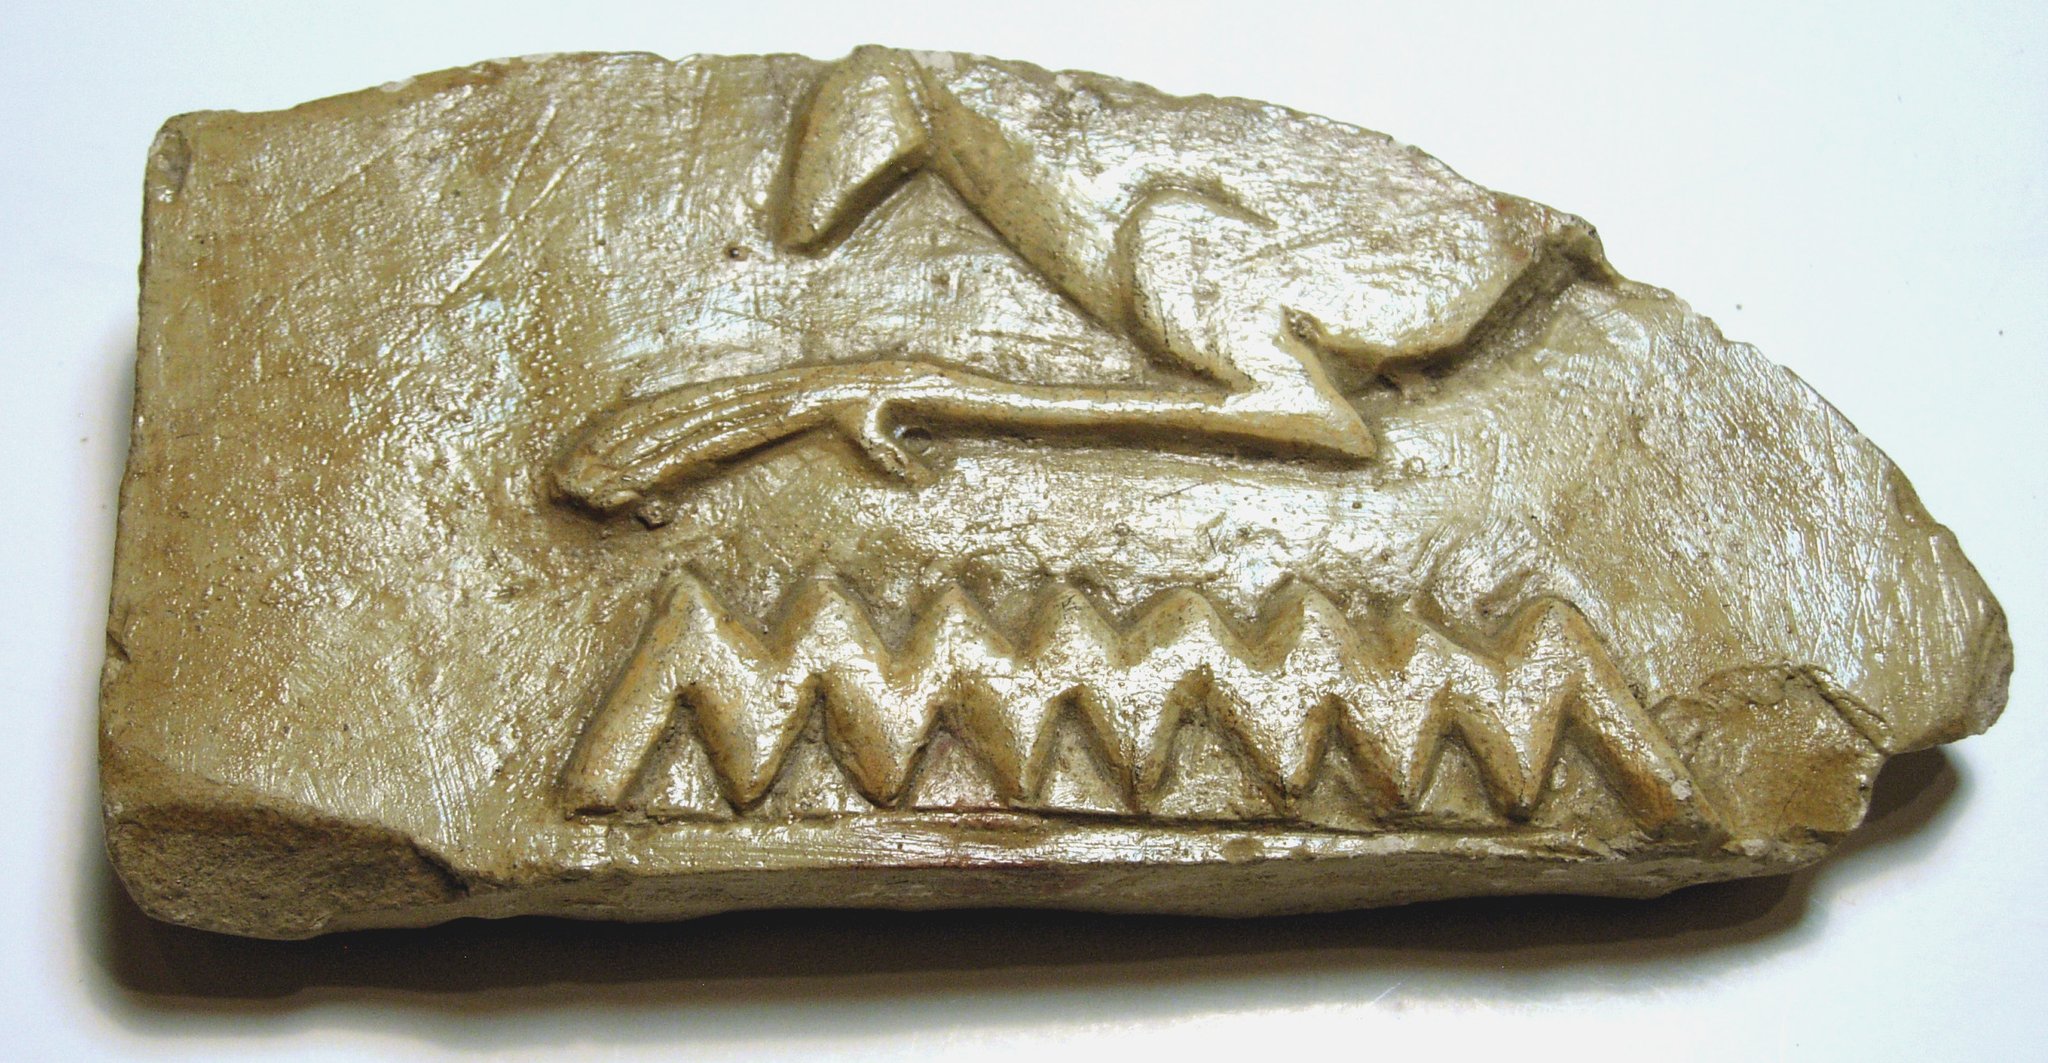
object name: relief, tomb of nespekashuty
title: Raised relief fragment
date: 664-610 BCE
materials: limestone, varnish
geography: egypt